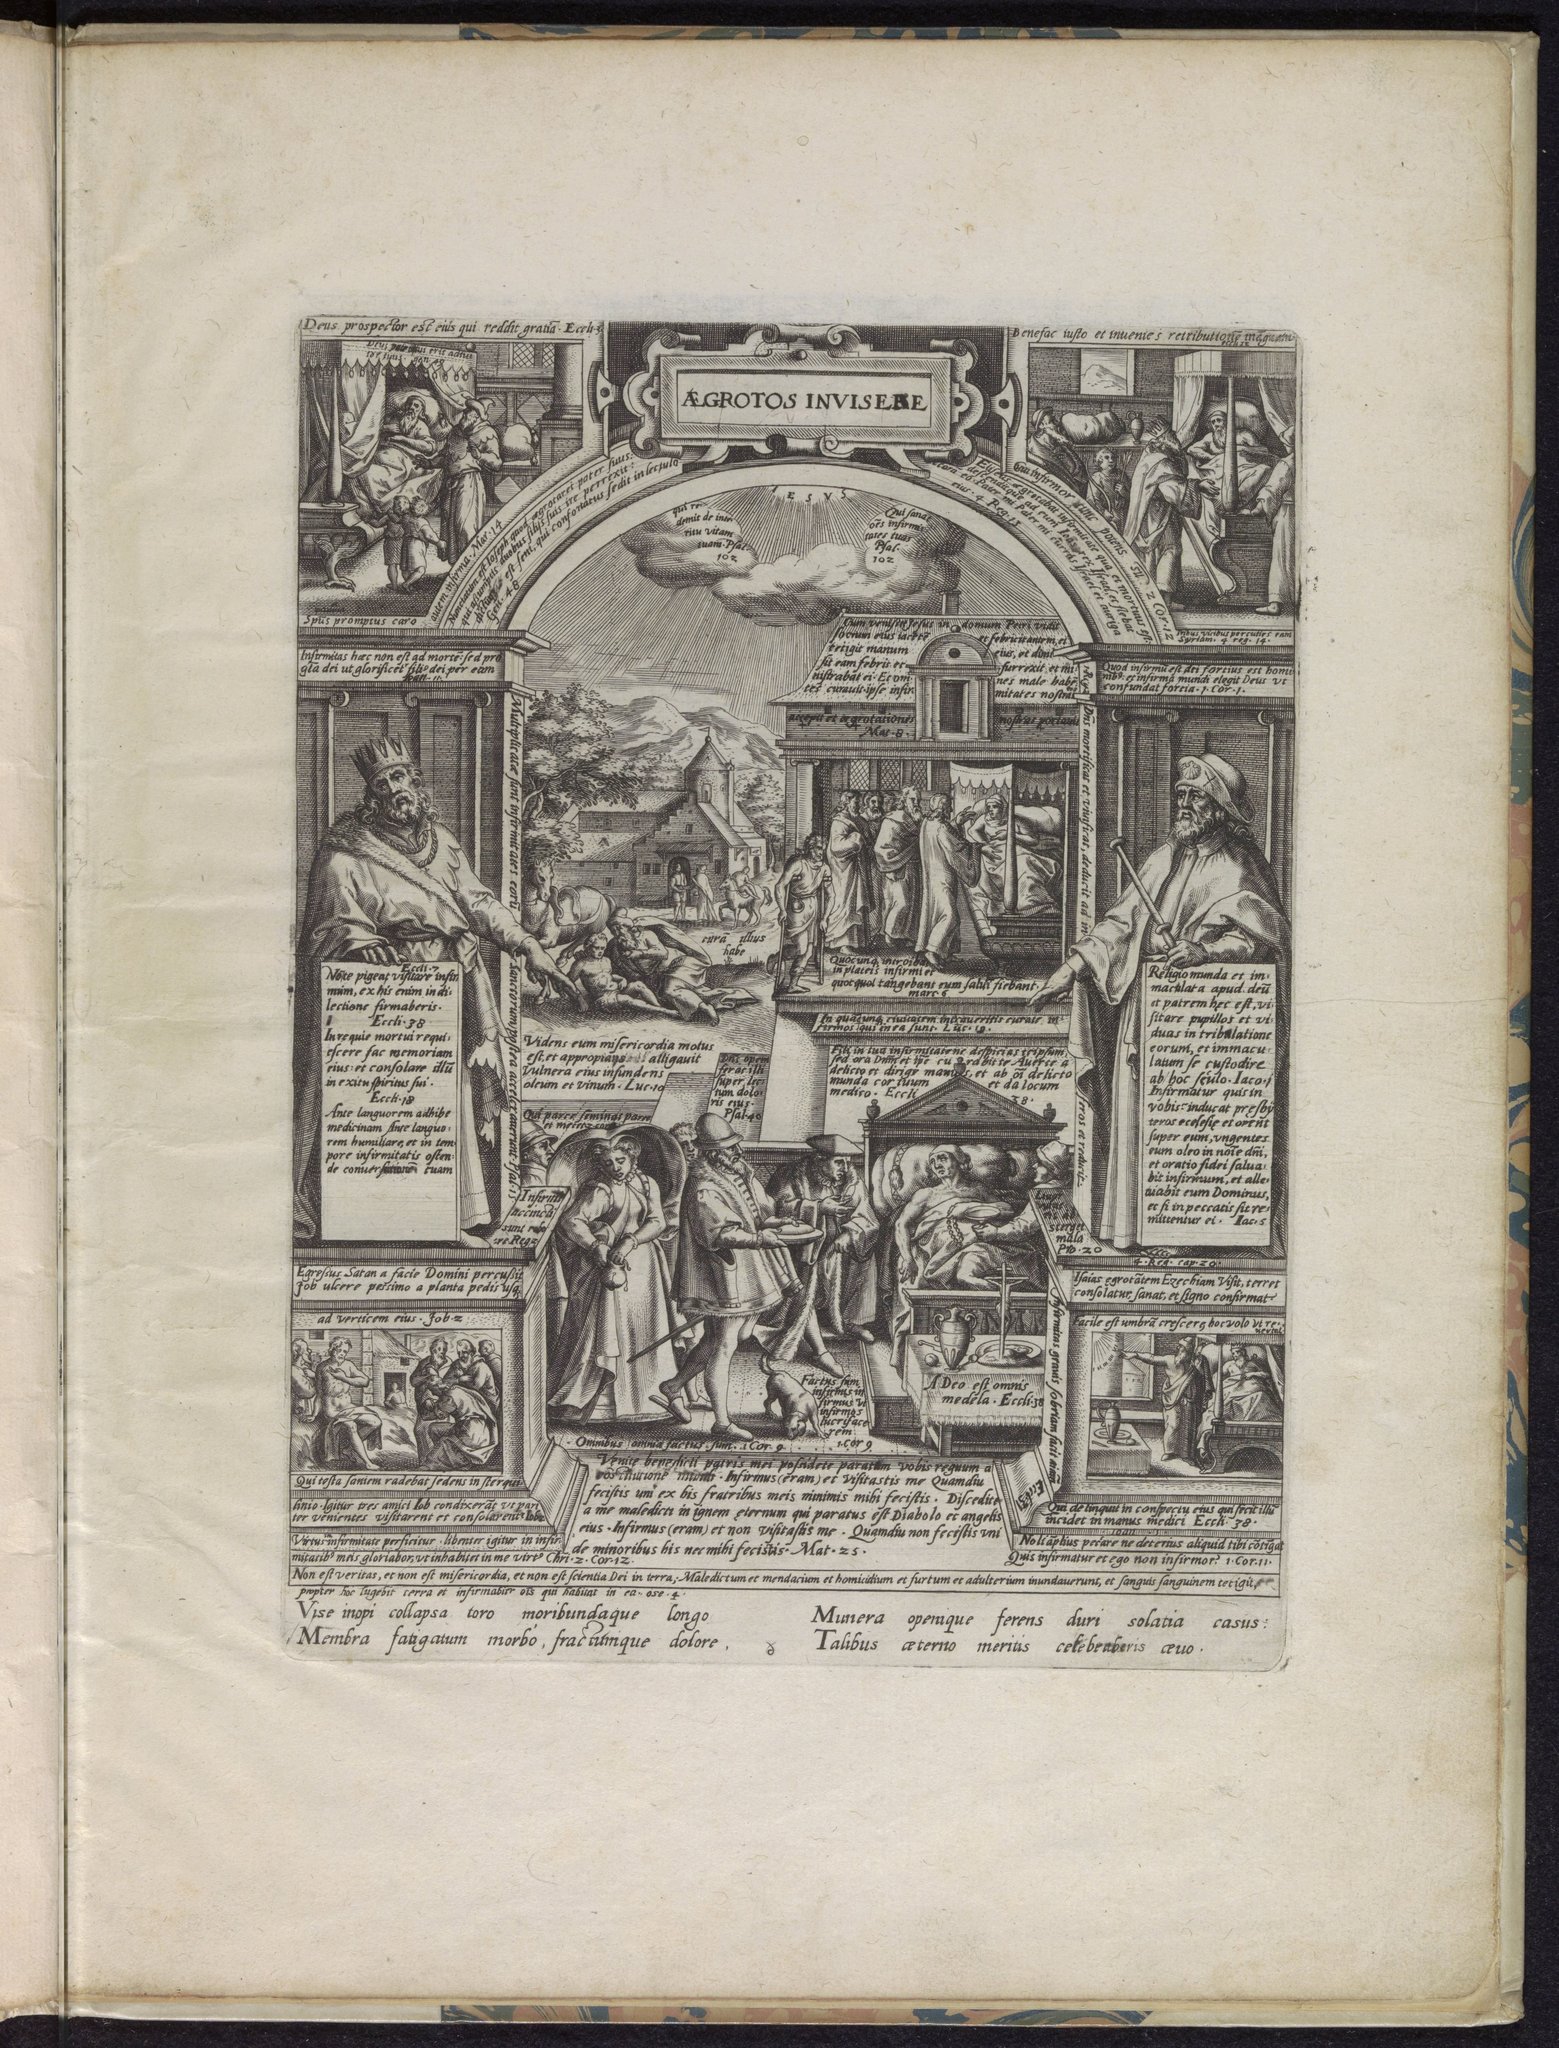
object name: album leaf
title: Aegrotos Invisere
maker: philips galle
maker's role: print maker, publisher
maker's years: 1537-1612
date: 1577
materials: paper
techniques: engraving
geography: antwerp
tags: the good samaritan (luke 10:30-37), visiting the sick, 'aeger curatur' ~ one of the (seven) acts of mercy, healing of peter's mother-in-law (matthew 8:14-15; mark 1:29-31; luke 4:38-39)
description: Het bezoeken van de zieken als een van de zeven werken van barmhartigheid. In het midden mensen die een zieke bezoeken. Op de achtergrond de barmhartige Samaritaan die voor de gewonde man zorgt en Christus die in een huis de schoonmoeder van Petrus geneest. Rondom voorstellingen van Bijbelverhalen die te maken hebben met het bezoeken van zieken. Linksonder Job op de mesthoop. Links koning Salomo en rechts Jakobus. In de voorstelling diverse Bijbelteksten in het Latijn. Onder de voorstelling een vierregelig vers in het Latijn. Deze prent maakt deel uit van een album.